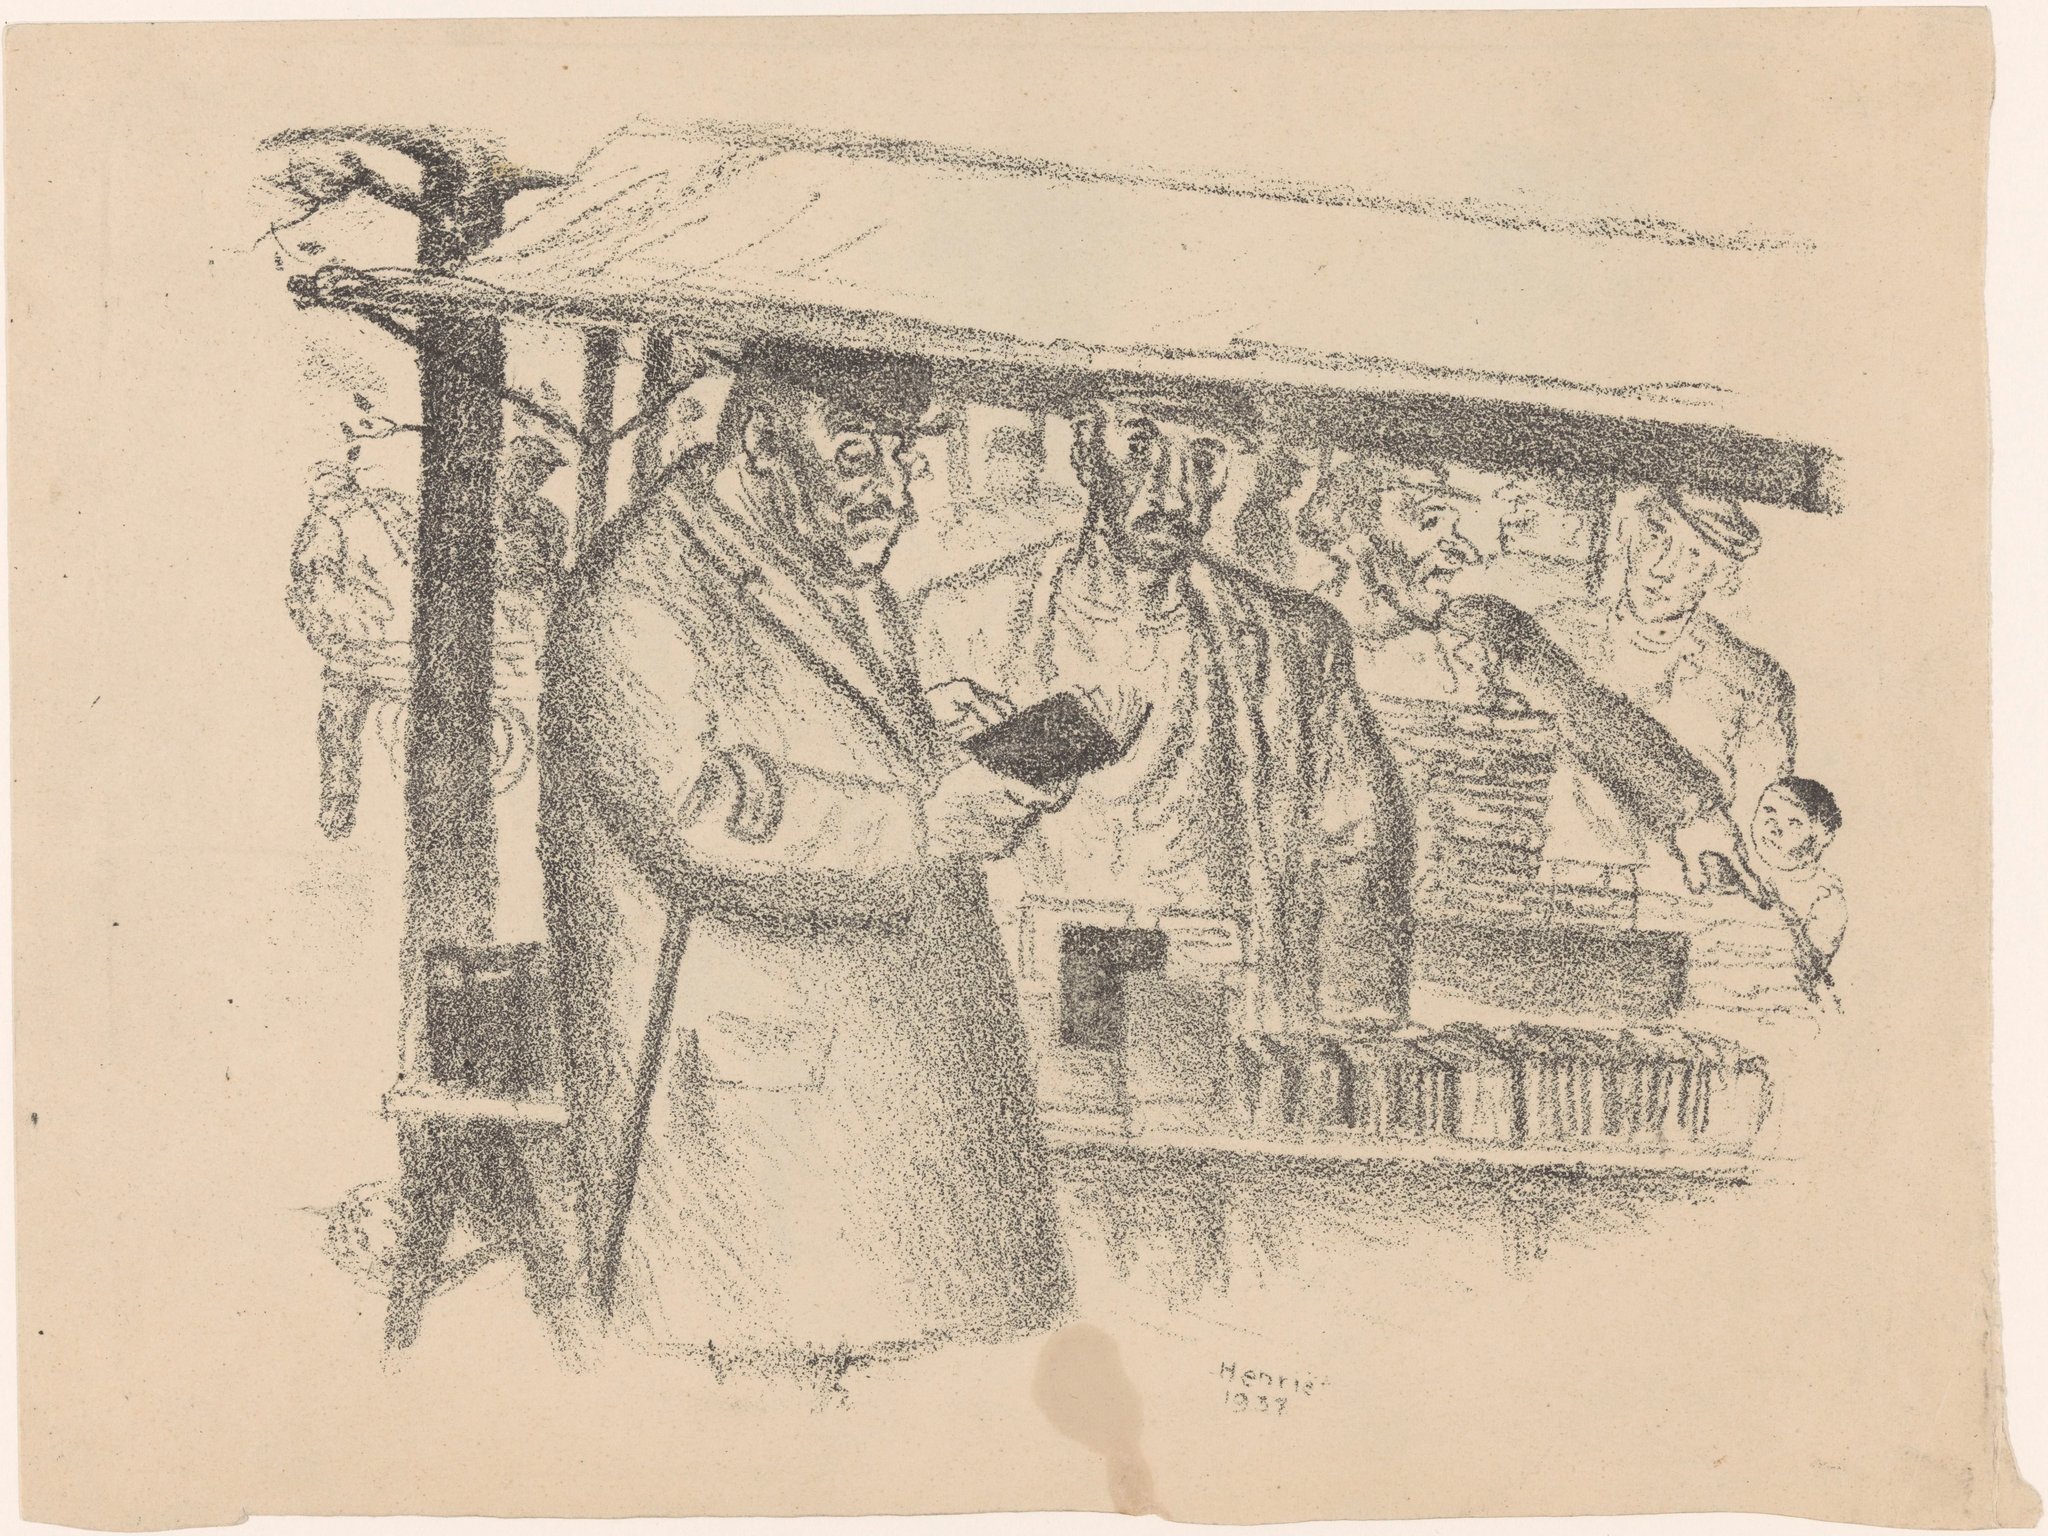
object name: print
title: Boekenkraam op een markt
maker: henk henriët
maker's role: draughtsman, print maker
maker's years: 1903-1945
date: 1937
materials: paper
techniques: lithograph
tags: book-stall, kiosk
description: Een man met bolhoed en wandelstok aan de arm kijkt bij een boekenkraam een boek in. De koopman kijkt toe.